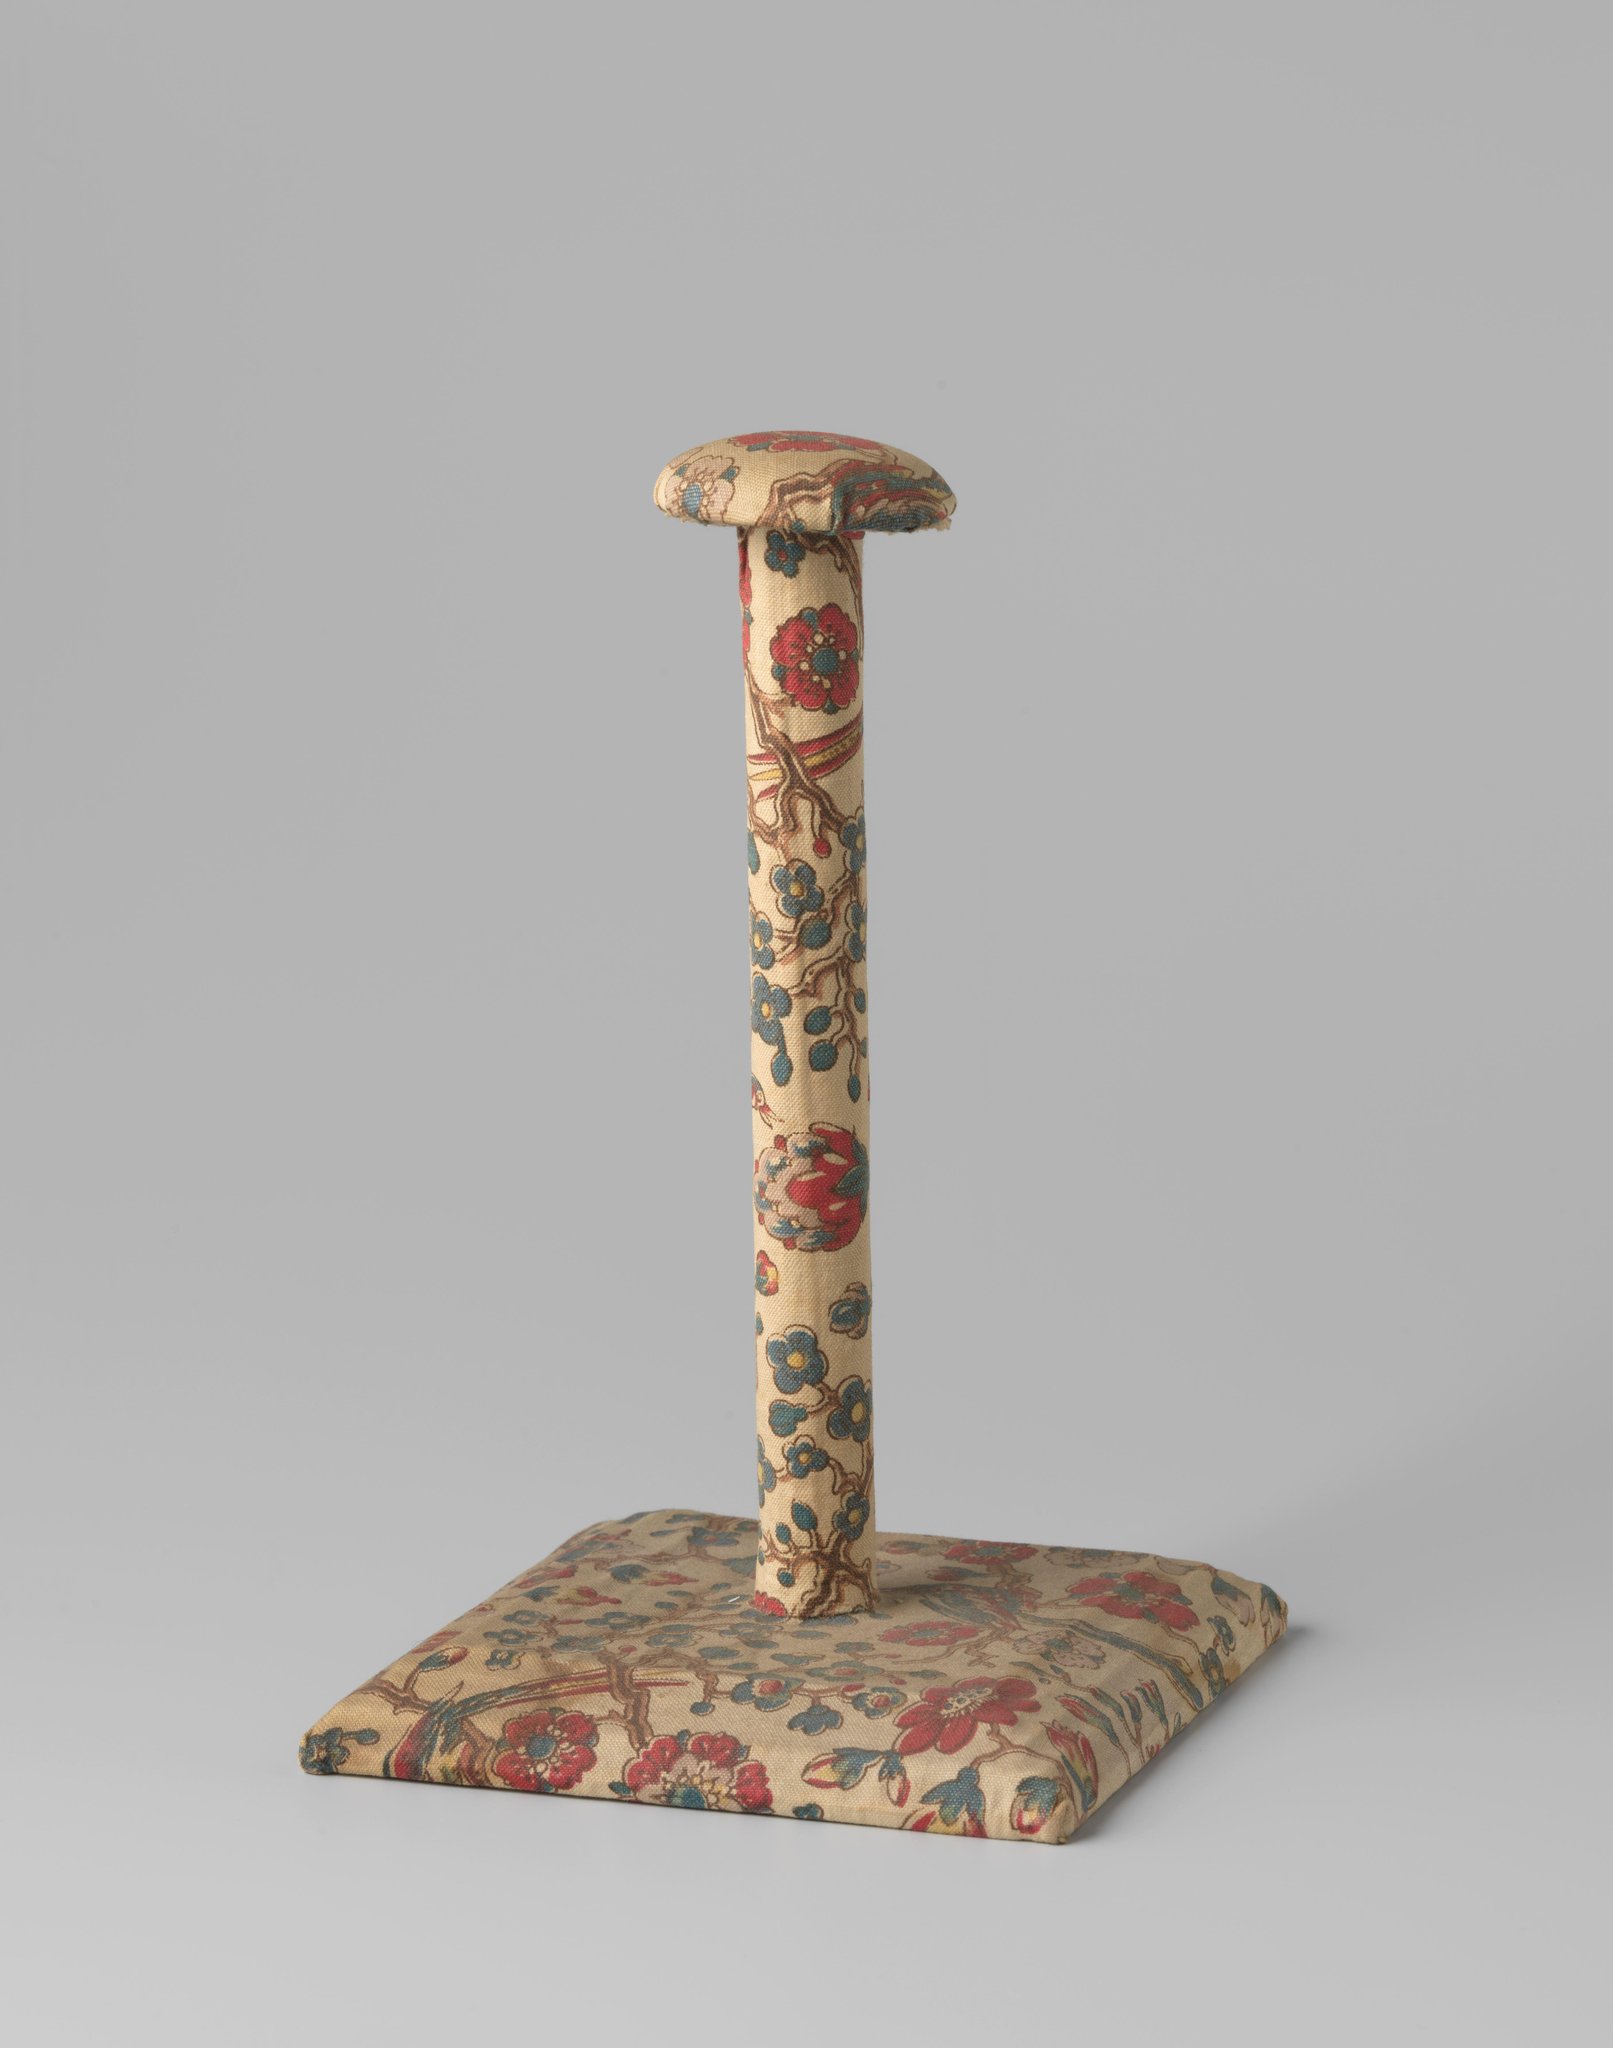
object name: hat stand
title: Hoedenstandaard bekleed met cretonne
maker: Anonymous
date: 1900-1949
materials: textile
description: Een kleine hoedenstandaard met een vierkante bodemstuk en een plat bolrond draagvlakje. Bekleed met cretonne.